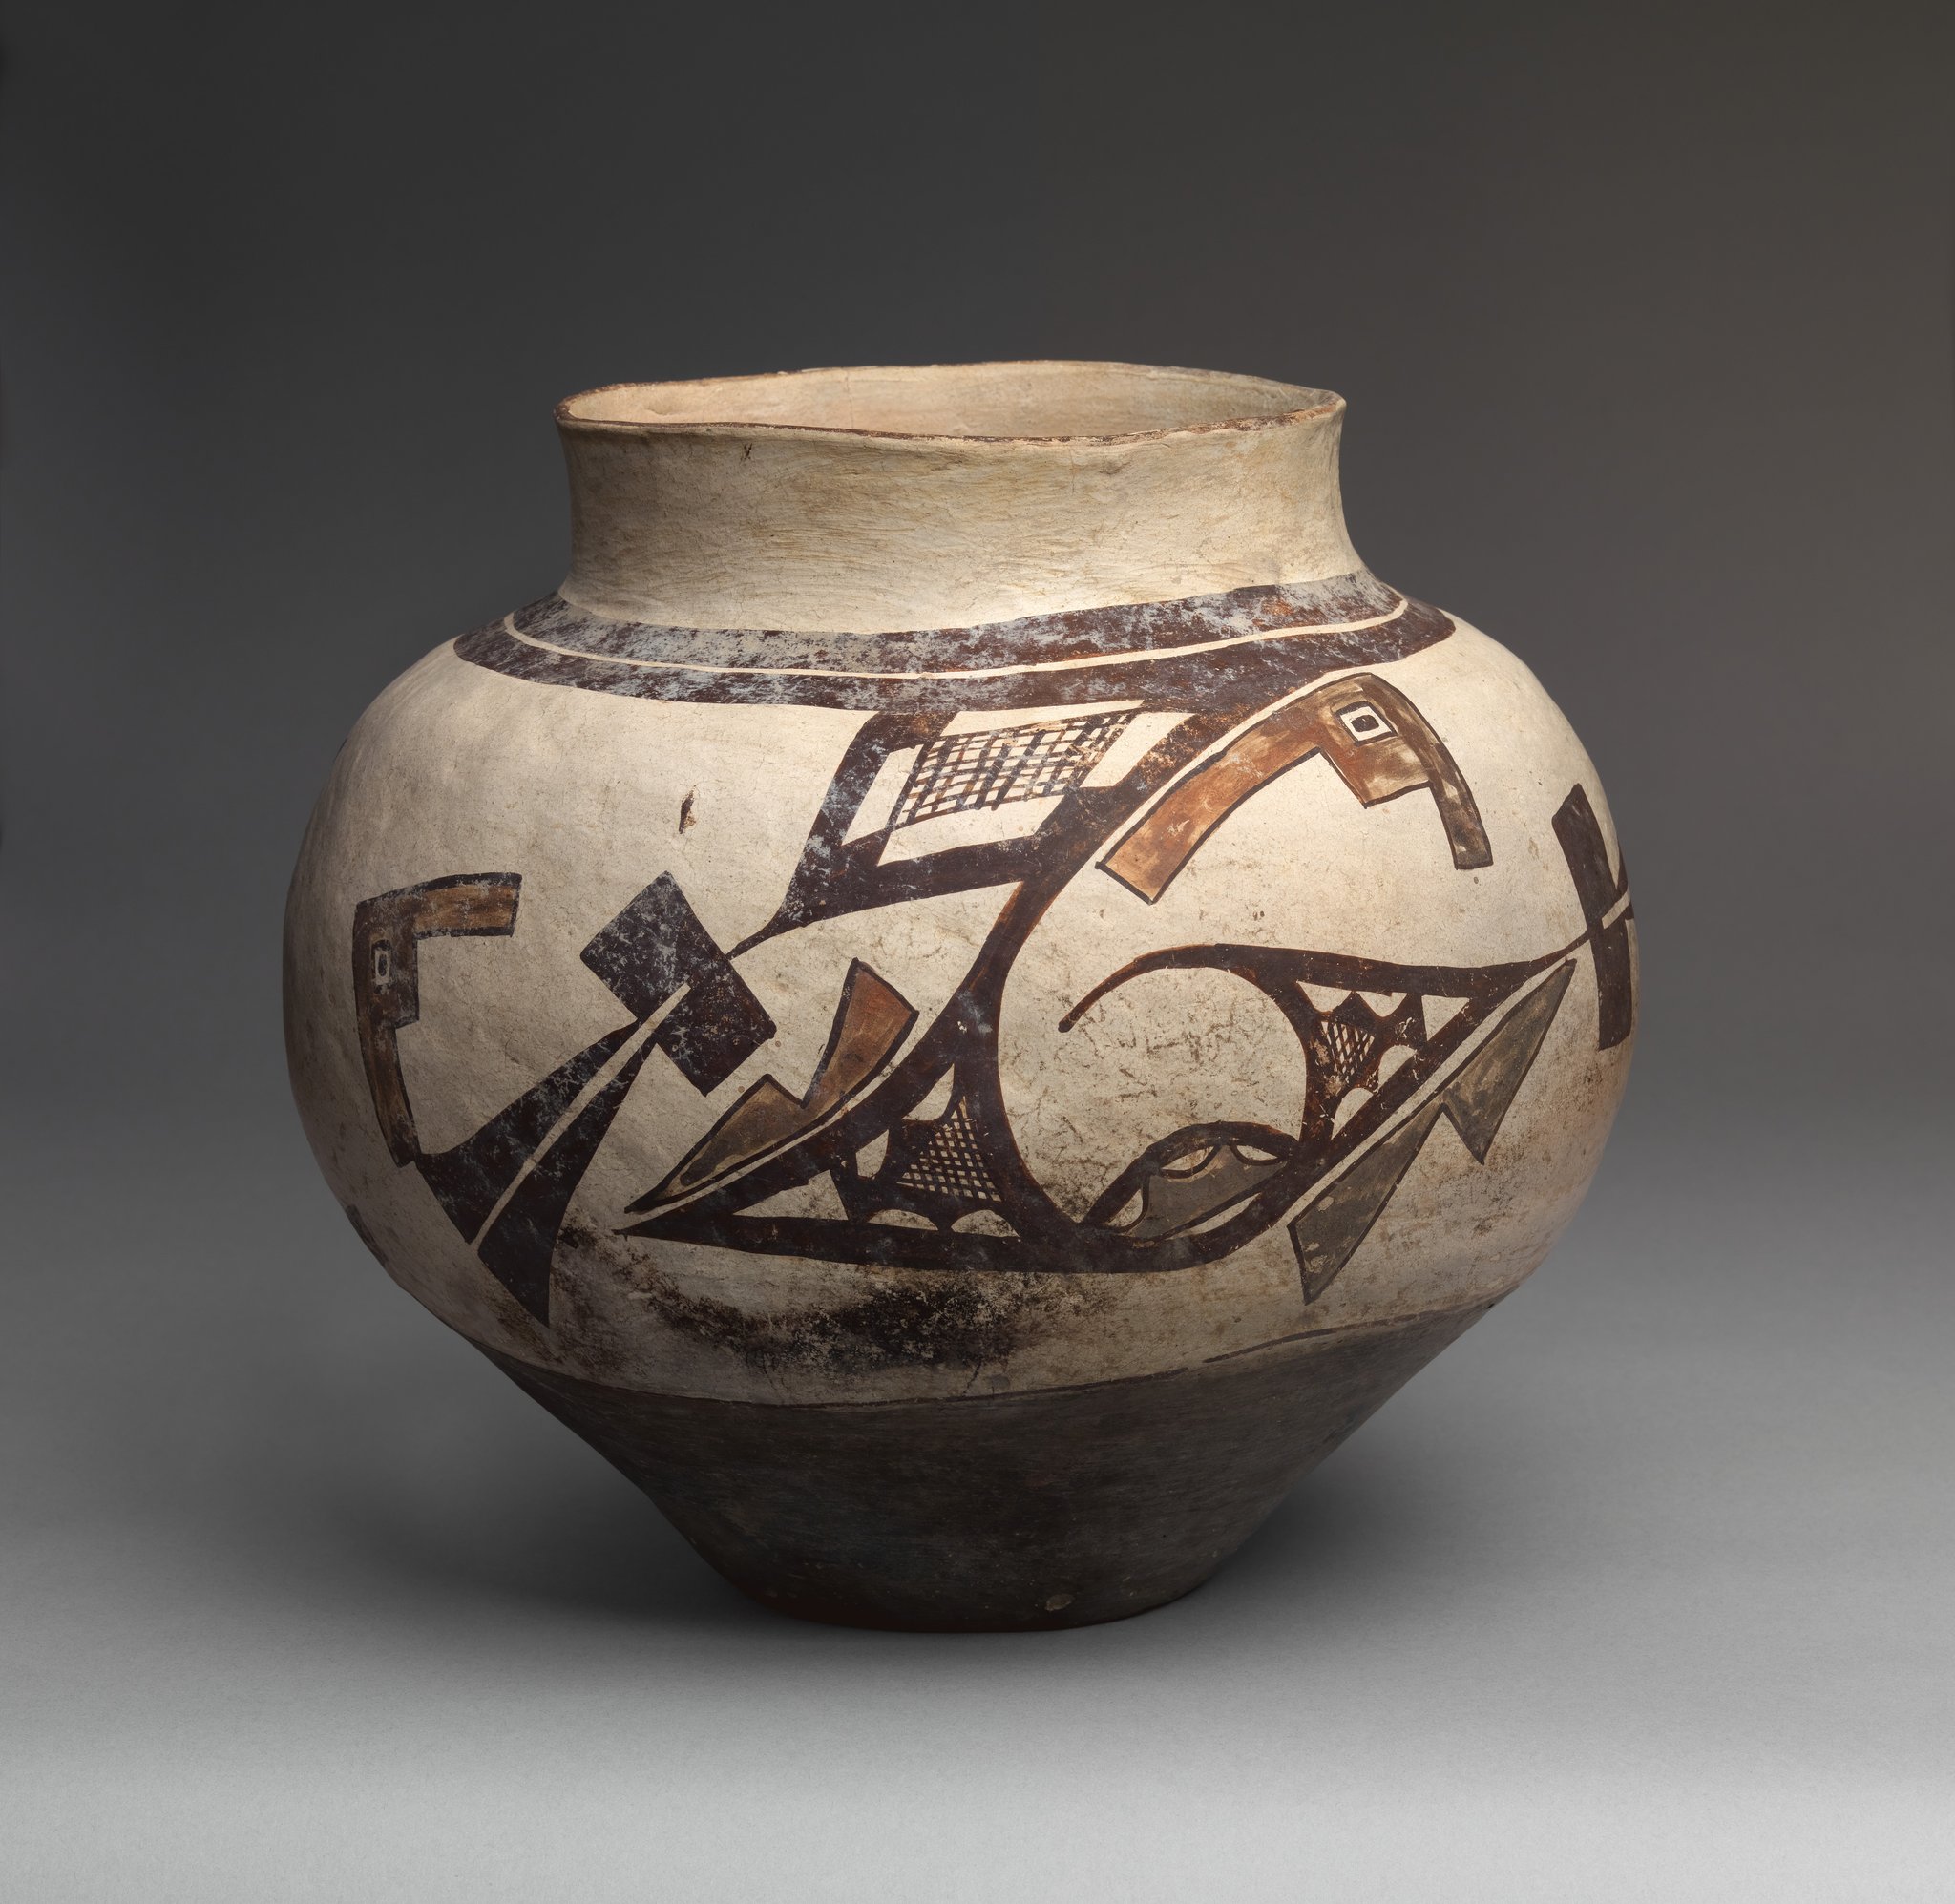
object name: water jar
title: Acomita polychrome water jar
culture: acoma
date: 1790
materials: clay, pigment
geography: united states